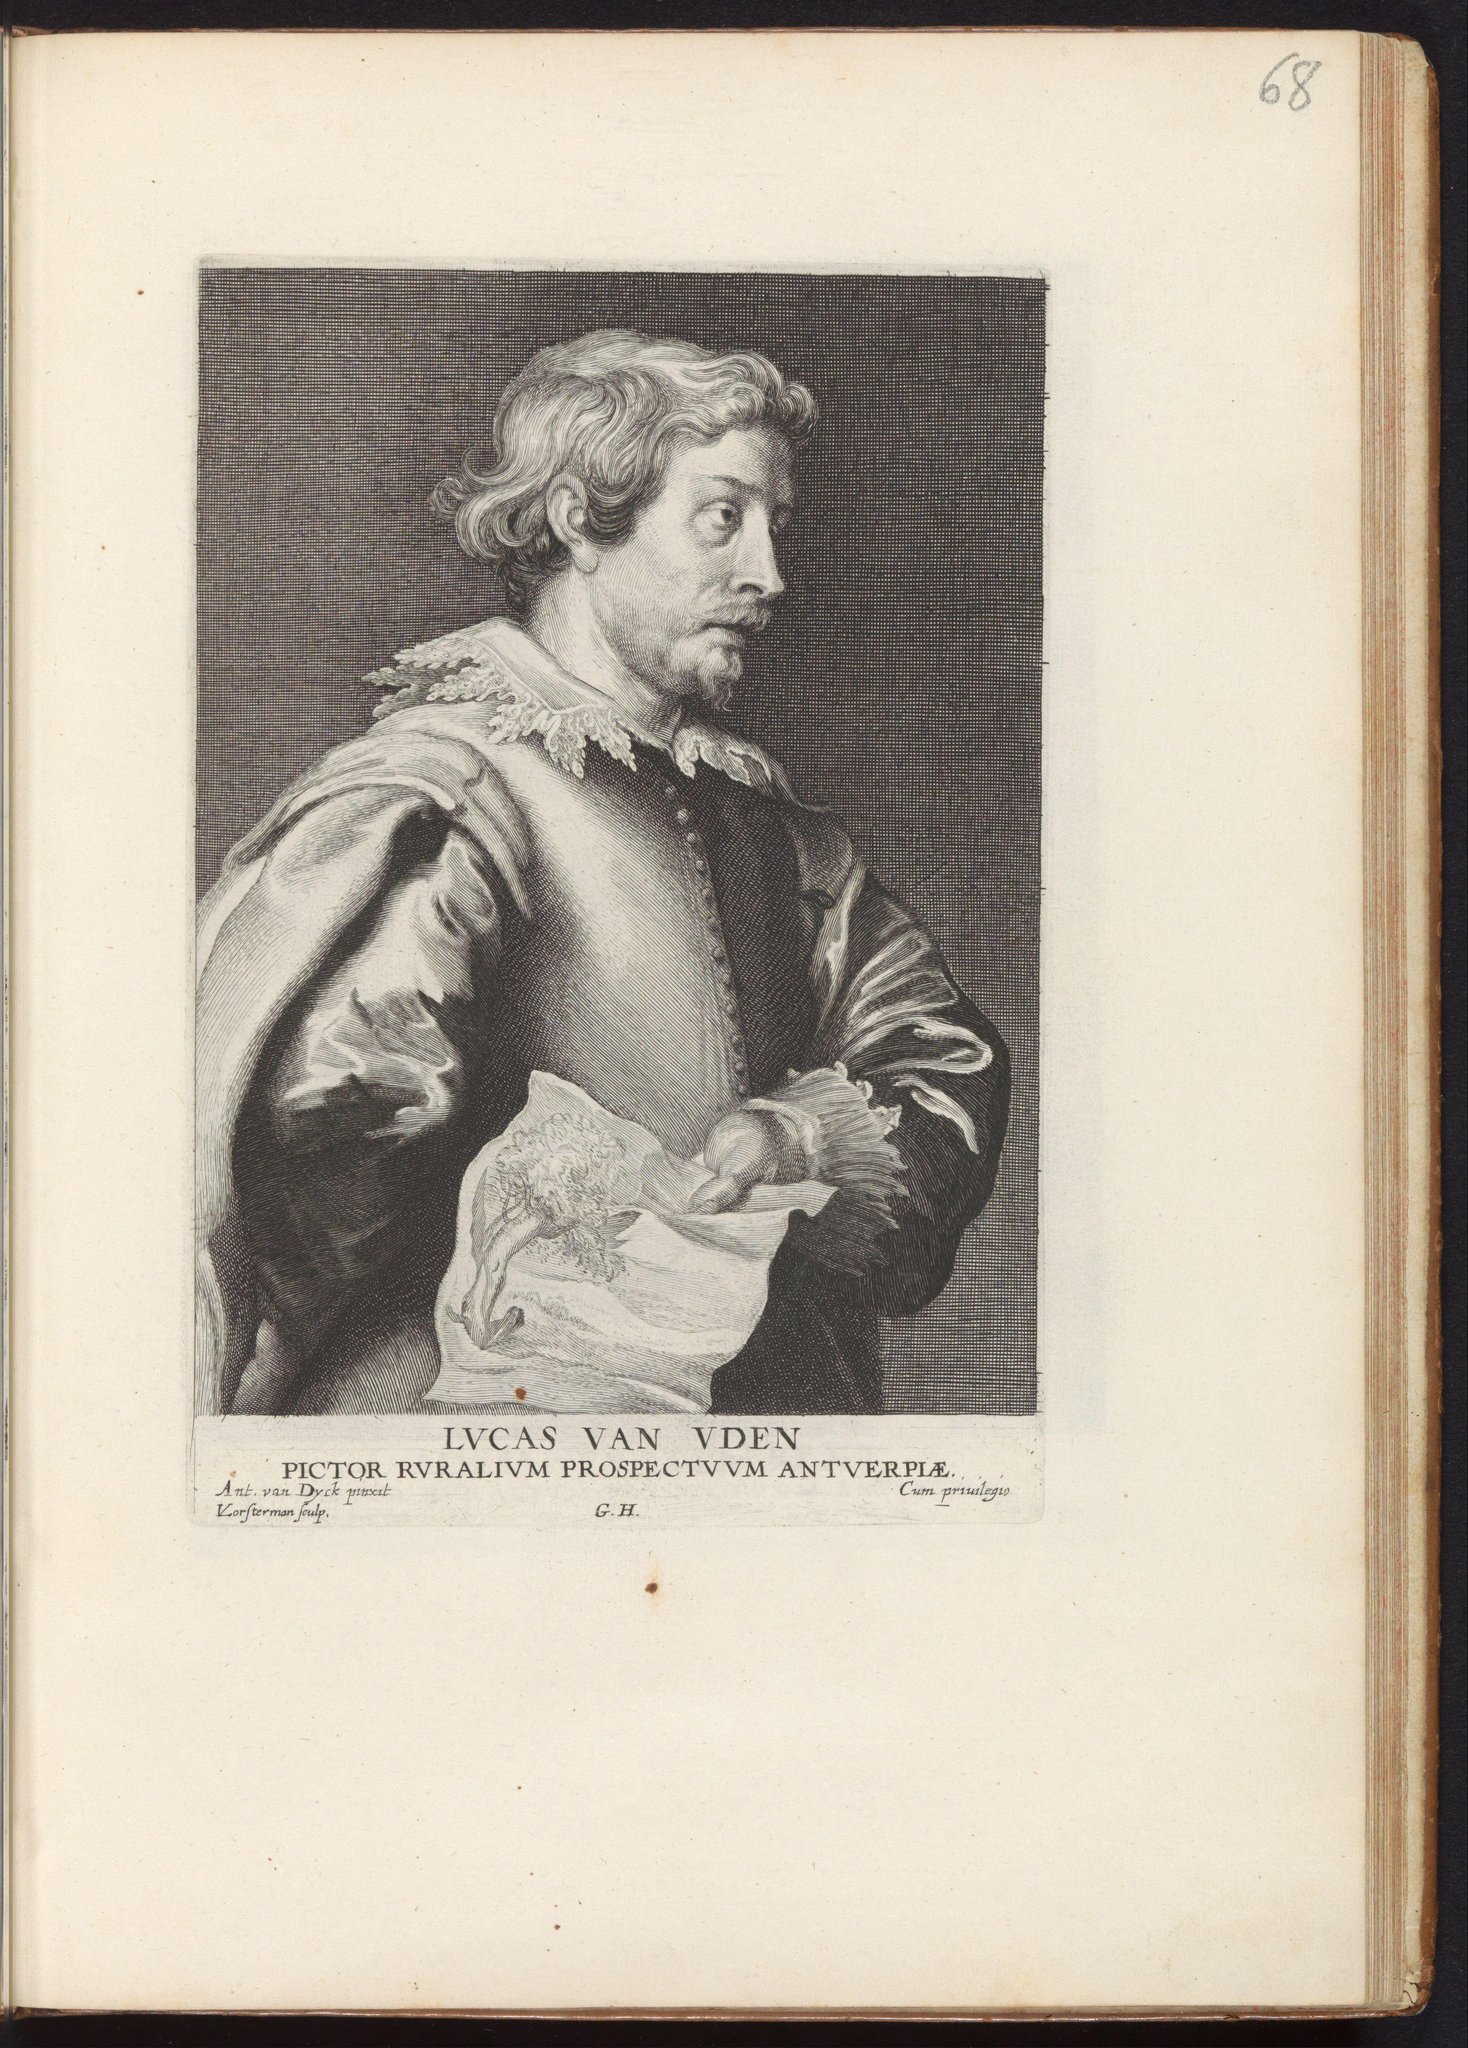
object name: print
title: Portret van Lucas van Uden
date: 1630-1641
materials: paper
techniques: engraving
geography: antwerp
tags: antwerp, print maker, draughtsman, lucas van uden, drawing, sketch, portrait, self-portrait of painter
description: Portret van de Antwerpse prentmaker en tekenaar Lucas van Uden. In zijn hand een tekening van een boom in een landschap. Deze prent maakt deel uit van een album.